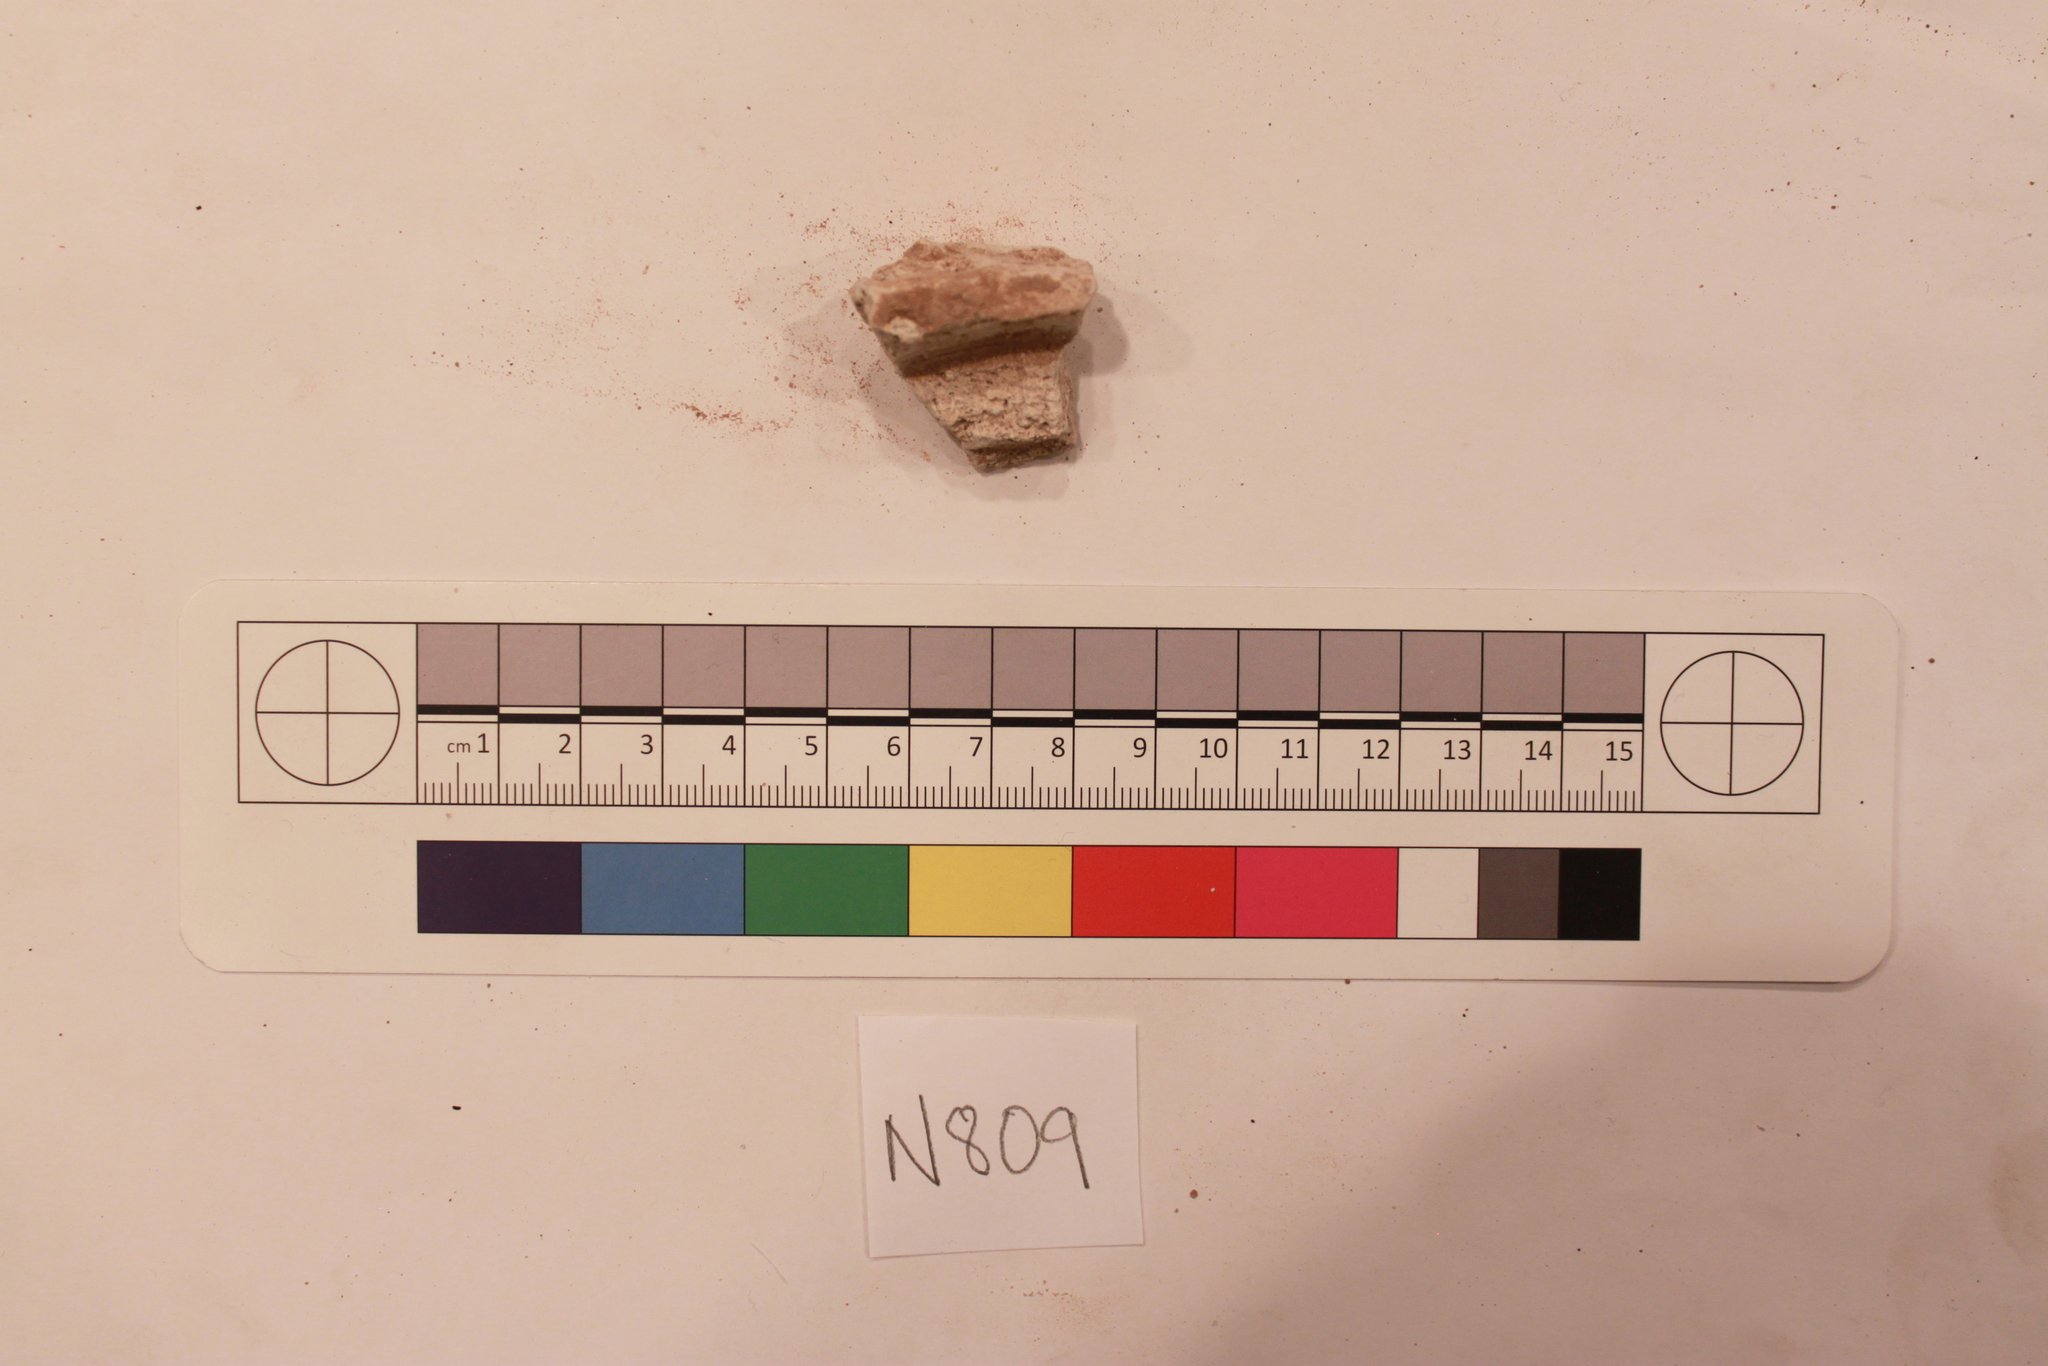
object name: fragment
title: Stucco Fragment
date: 701-1200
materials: plaster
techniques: carving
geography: iran